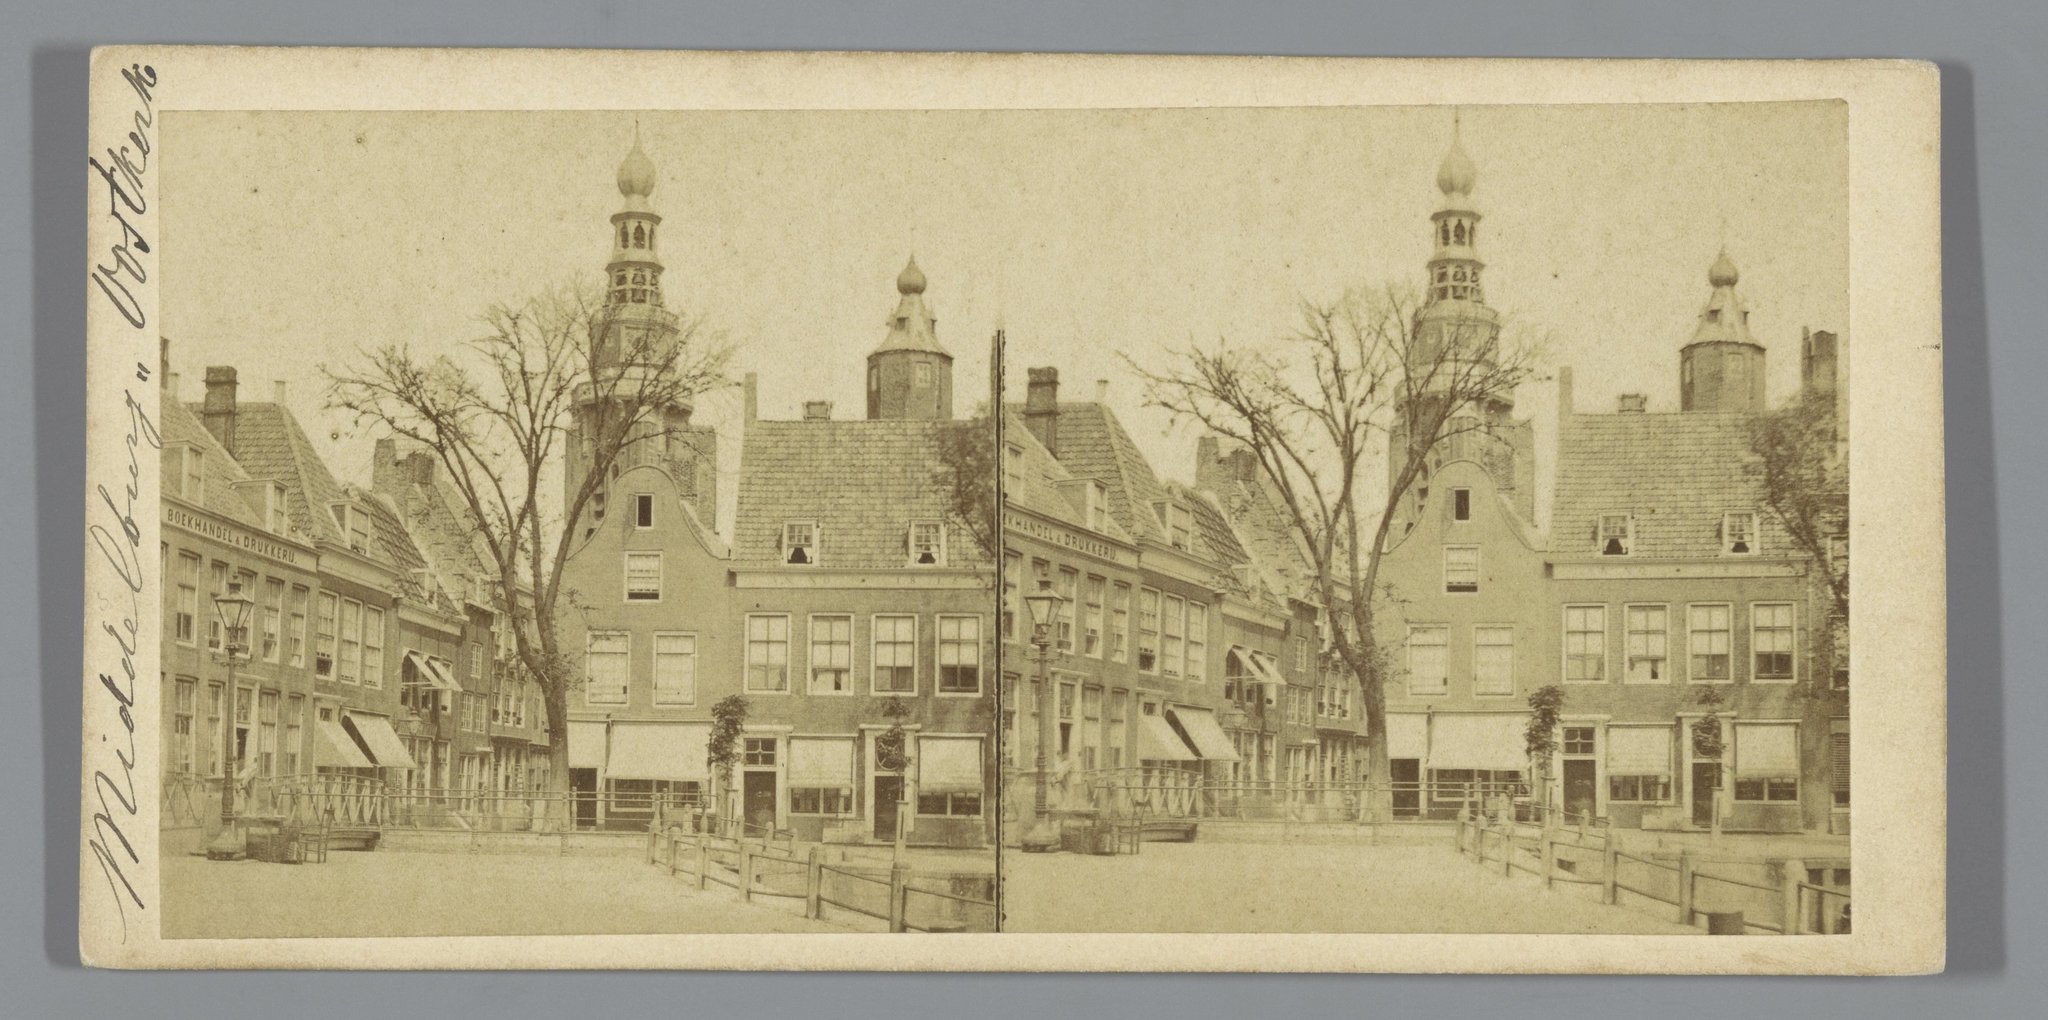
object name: stereograph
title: Straat in Vlissingen, met de toren van de Grote of Sint-Jacobskerk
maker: pieter oosterhuis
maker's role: draughtsman, print maker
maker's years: 1816-1885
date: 1859-1870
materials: cardboard, paper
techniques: albumen print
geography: flushing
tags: street, parts of church exterior and annexes: tower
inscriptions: number: ‘No. 1’, inscription: ‘P.’, number: ‘33’, number: ‘1’, inscription: ‘Middelburg/ Oostkerk’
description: In tegenstelling tot de titel op het object is hier niet de Oostkerk is Middelburg afgebeeld.